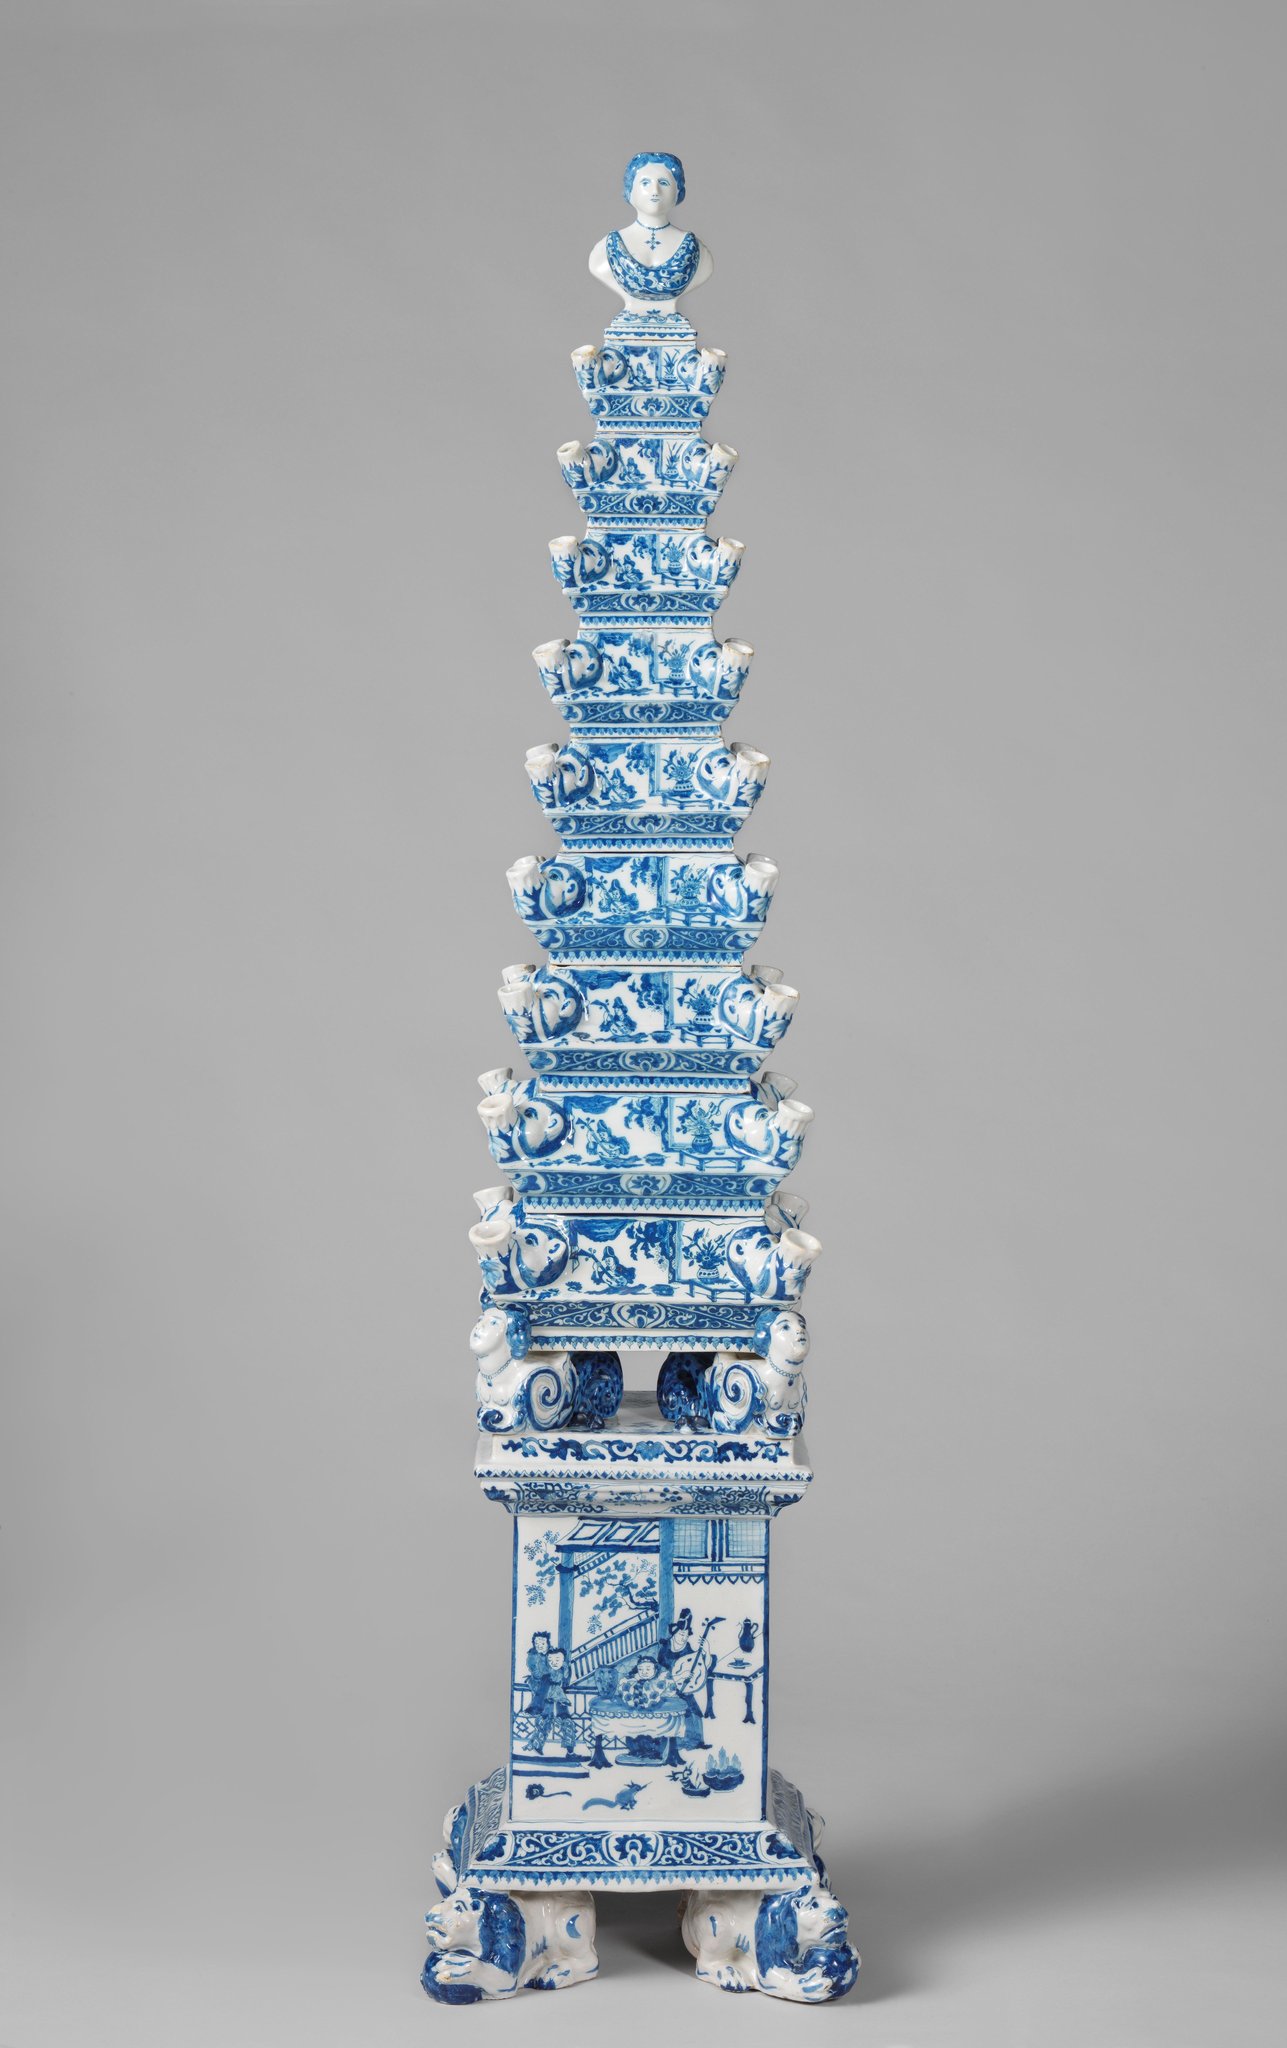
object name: bloempiramide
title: Flower pyramid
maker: lambertus van eenhoorn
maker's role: plateelbakker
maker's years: 1651-1721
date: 1692-1700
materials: earthenware, glaze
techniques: painted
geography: delft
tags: flowers, one person playing string instrument (plucked), beasts of prey, predatory animals: lion, chest, bust - aa - female human figure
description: Segment van bloempiramide van faience, blauw beschilderd in de glazuur. Musicerende figuren en figuren met schaal.